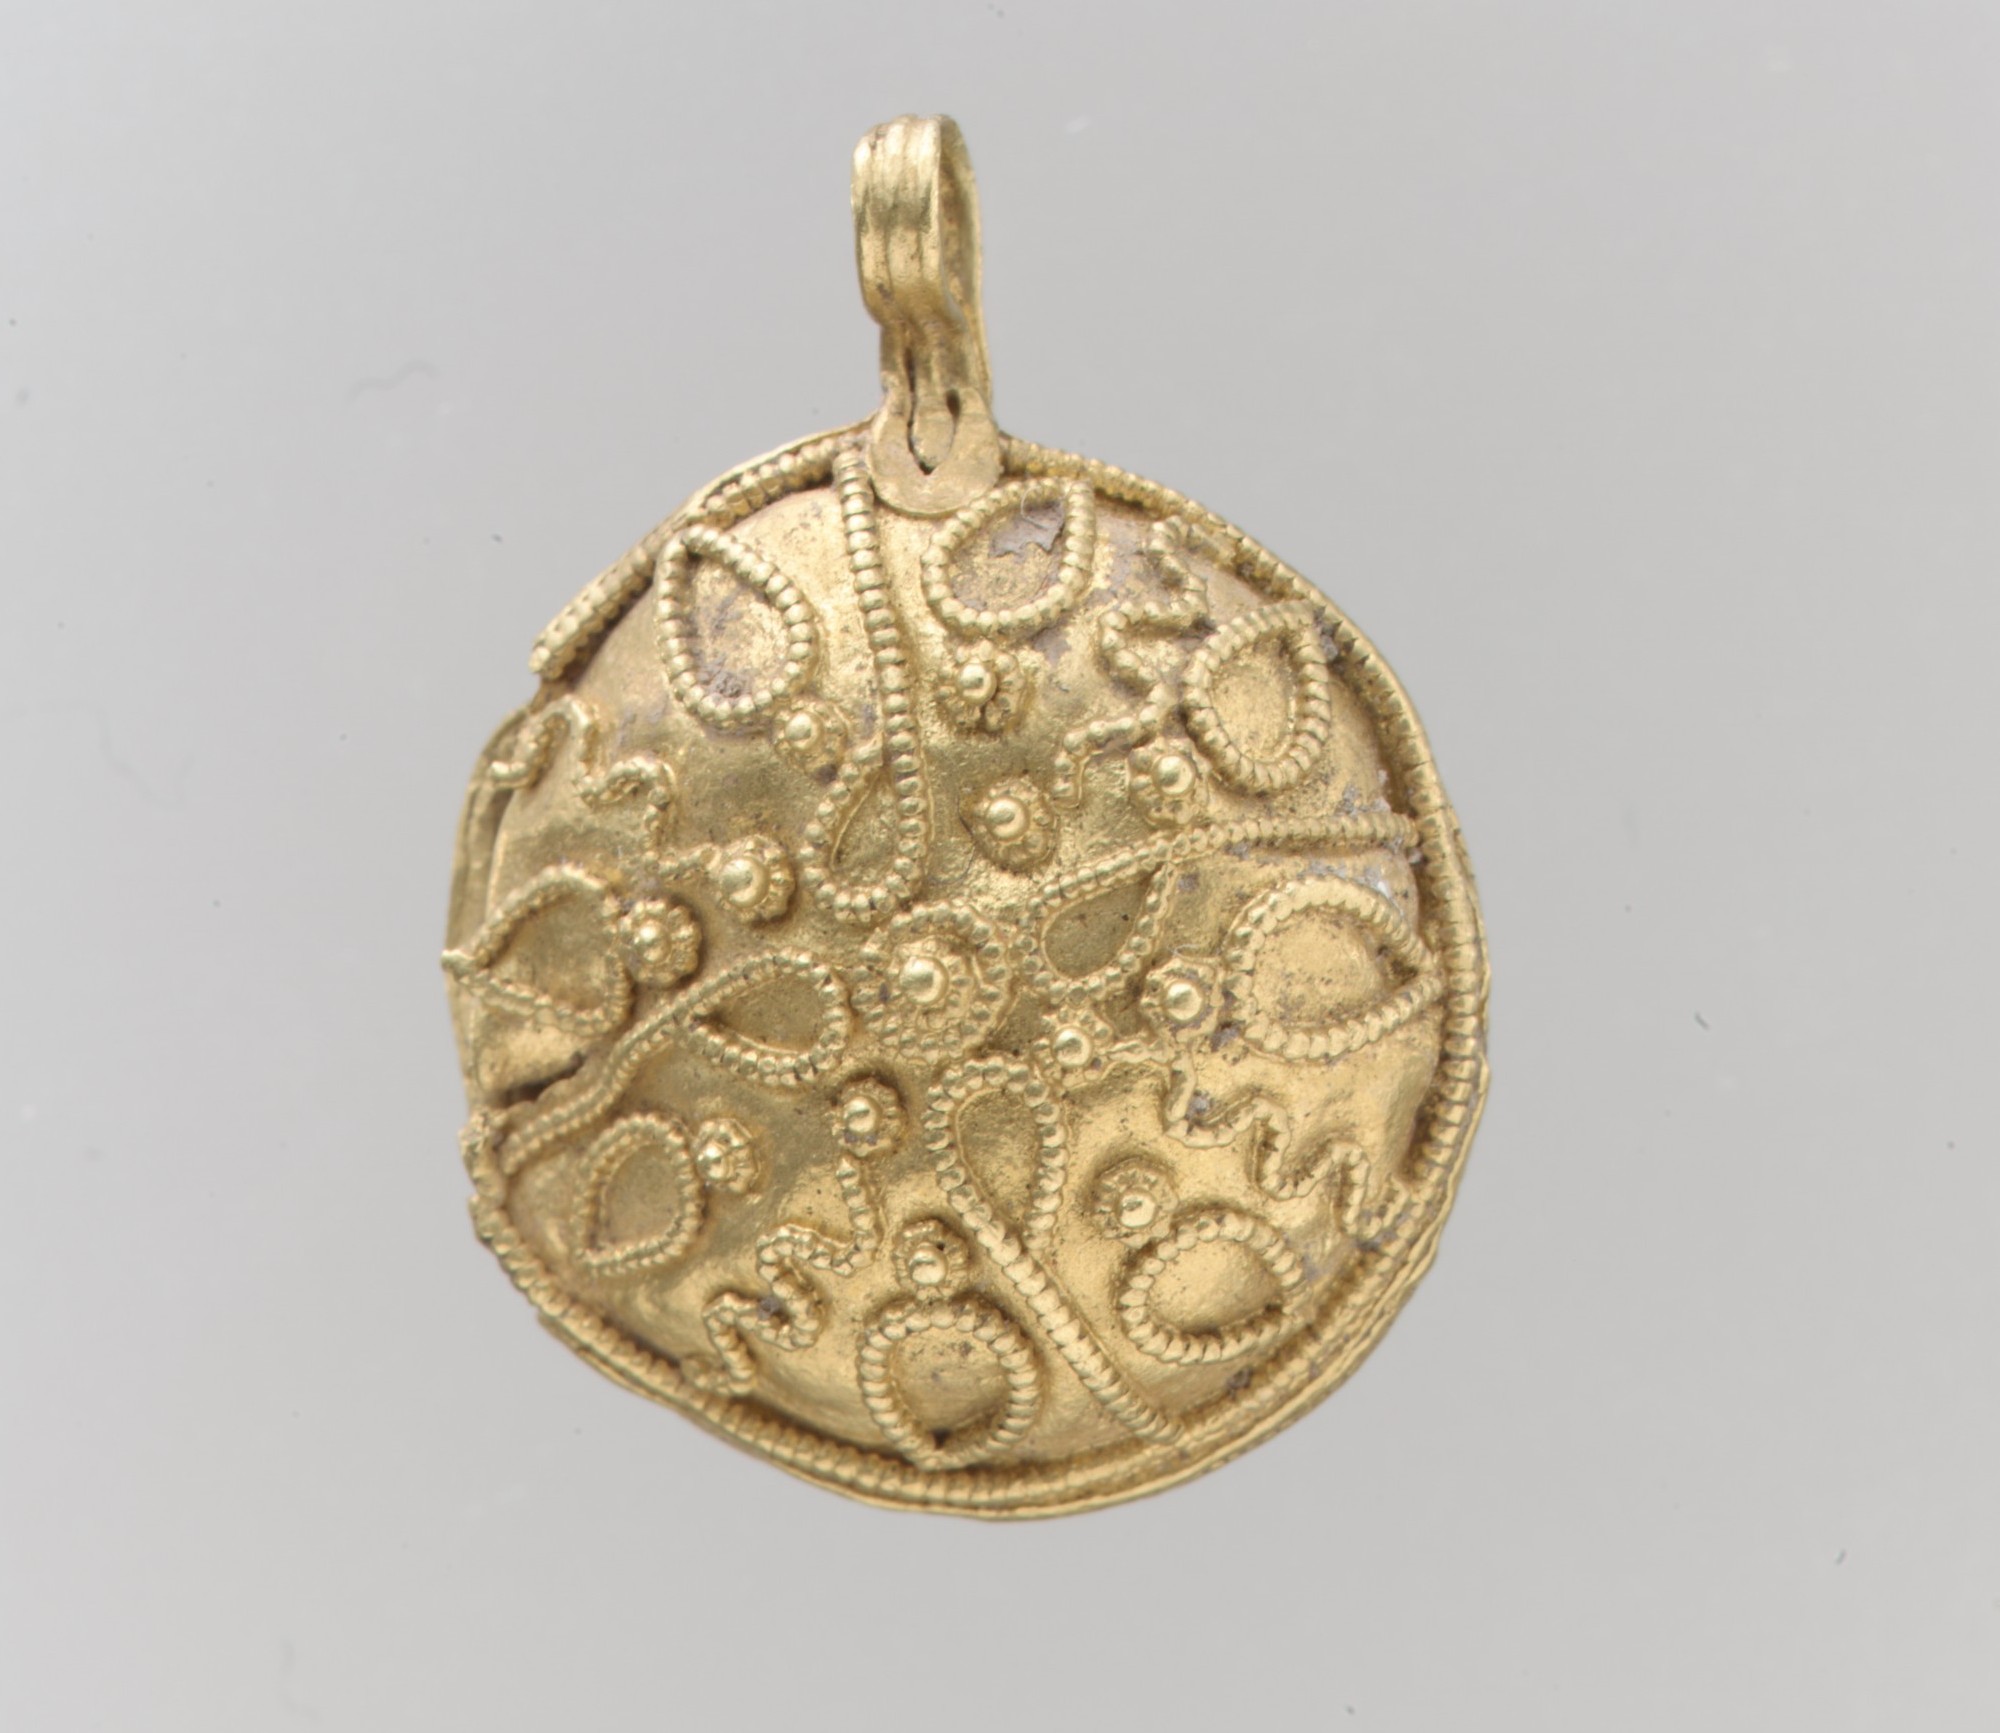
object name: pendant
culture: langobardic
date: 501-700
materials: gold